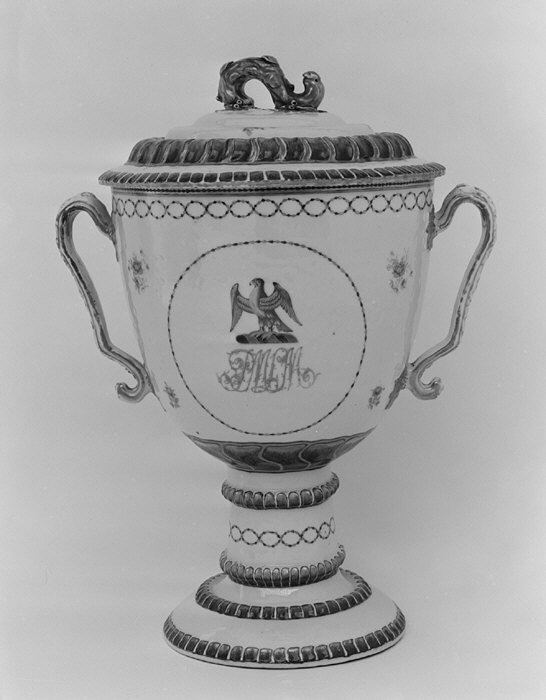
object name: cup with cover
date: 1785-1800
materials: hard paste porcelain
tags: birds,insignia